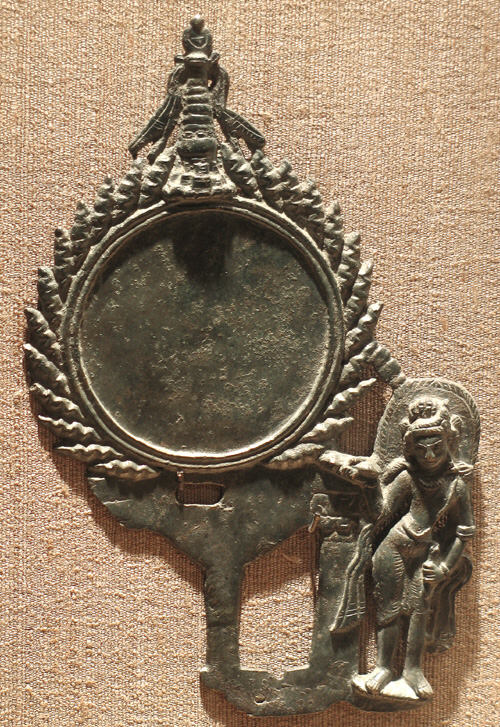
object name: halo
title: Buddhist Halo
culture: pakistani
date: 701-900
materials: bronze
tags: swat valley,buddhism